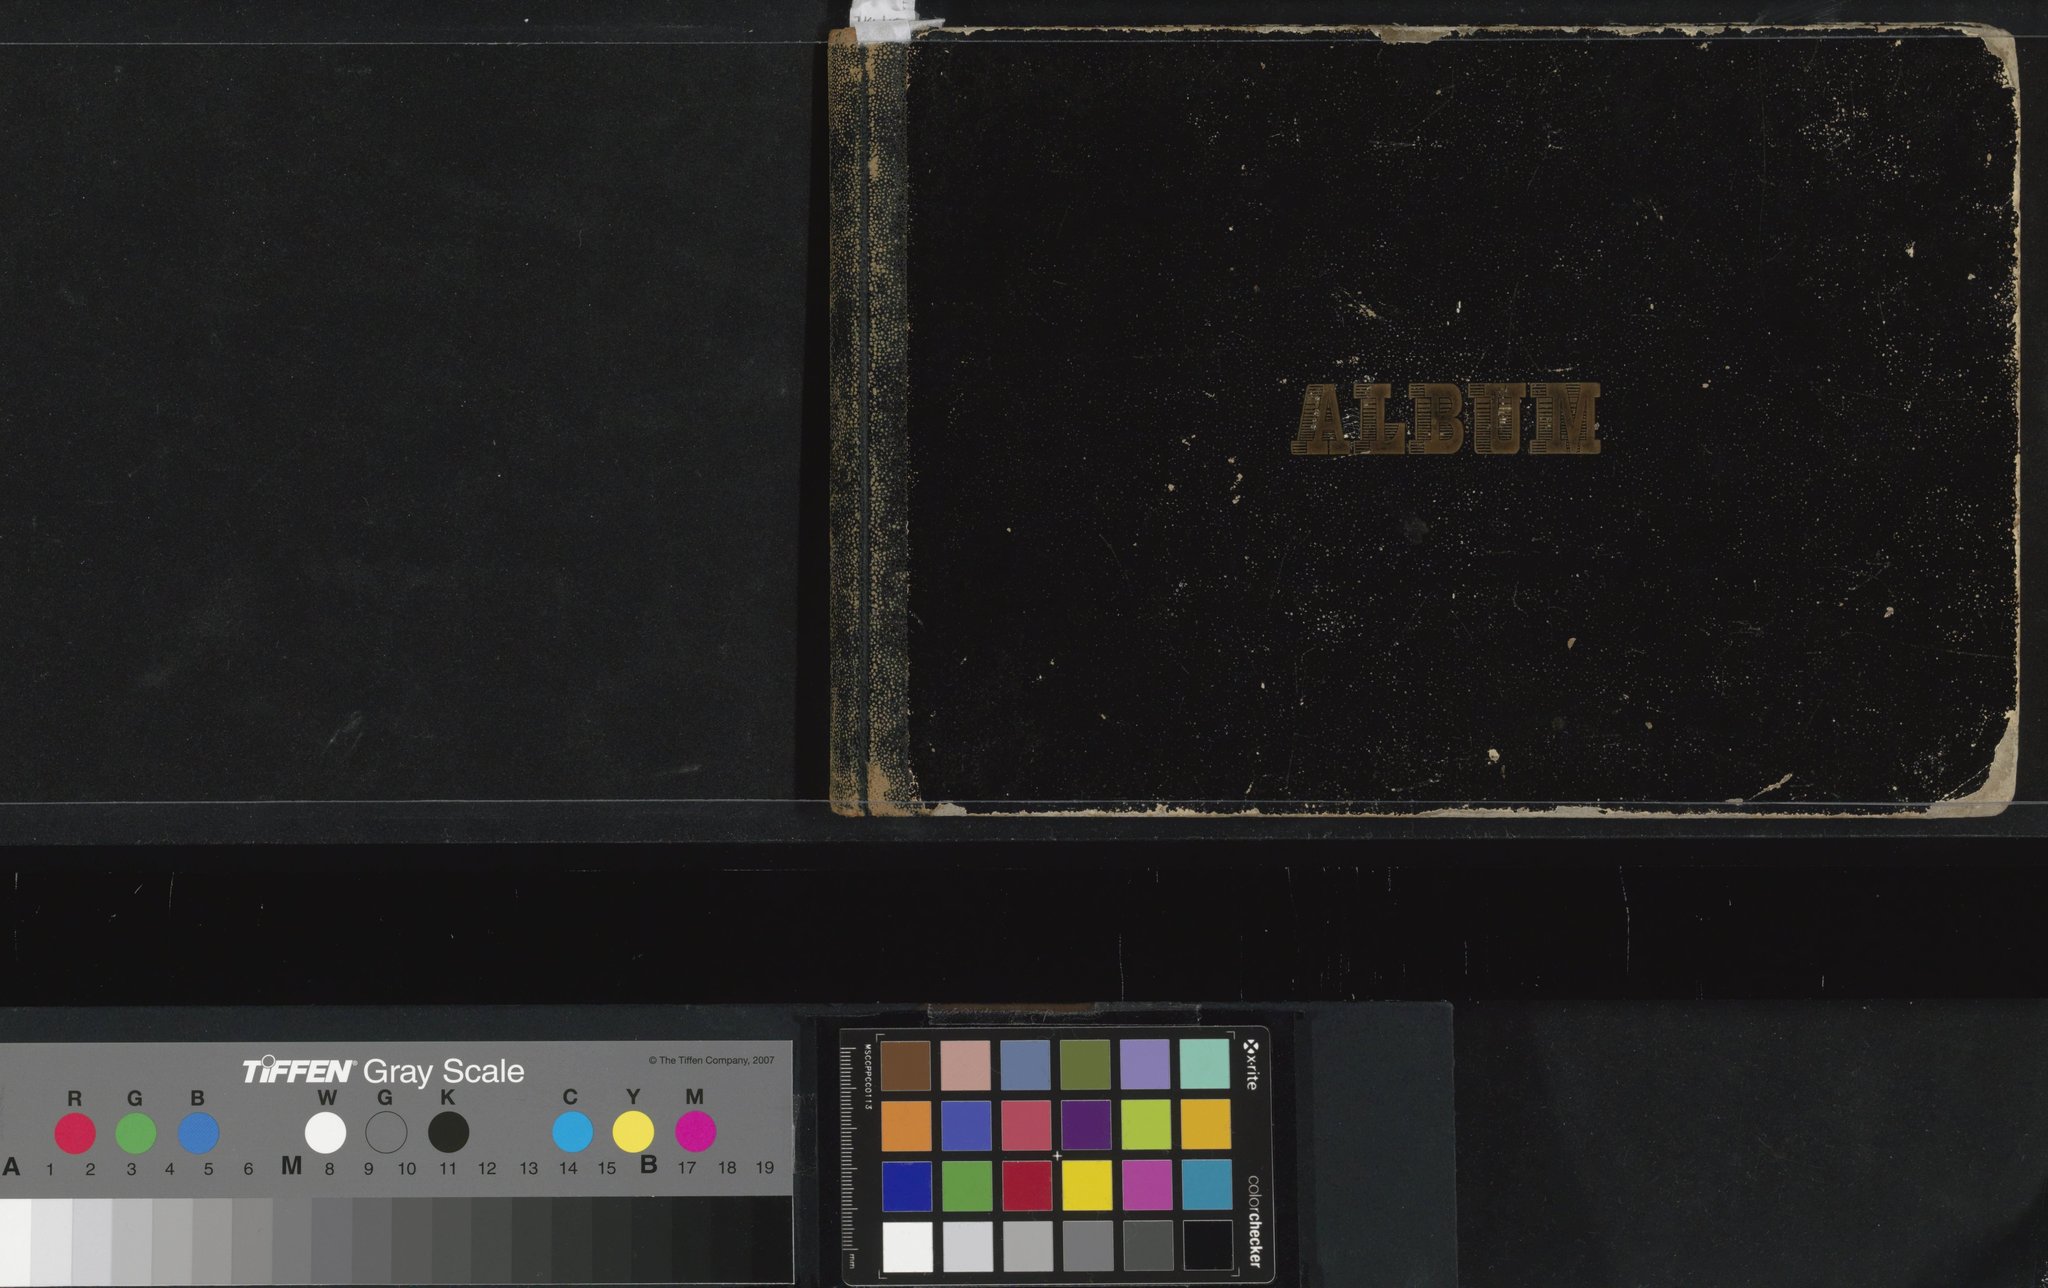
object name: sketchbook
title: Schetsboek met 58 bladen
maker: isaac gosschalk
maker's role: draughtsman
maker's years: 1838-1907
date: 1862-1867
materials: ink, leather, paper, pencil, watercolor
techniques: brush, pen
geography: arnay-le-duc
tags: architectural detail, representation of real building (either existing or having existed), rotterdam, utrecht, amsterdam, gouda, hoorn (north holland)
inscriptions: date and inscription: ‘Schetsboek van den architect / I. Gosschalk – Amsterdam 1862-67 Jos H.G./ architectuur en ornamenten, meest naar de natuur/ stadsgezichten of gebouwen uit:/ Amsterdam (Vijgendam enz.)/ Naarden/ Utrecht/ Rotterdam/ Gouda/ Zwolle/ Alkmaar/ Bergen/ Hoorn/ Amsterdam/ Utrecht/ Bommel’, collector's mark: Lugt 2228a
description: Schetsboek bestaande uit 58 bladen met architectuurstudies in onder andere Amsterdam, Uelzen, Naarden, Baarn, Amersfoort, Utrecht, Rotterdam, Gouda, Zwolle, Alkmaar, Bergen, Hoorn, Arnay-le-Duc, Berlijn en Bommel. Bij het schetsboek zijn tevens twee documenten gevoegd: een uittreksel uit het geboorteregister van Amsterdam met de aangifte van de geboorte van de kunstenaar en een brief van Prins Hendrik der Nederlanden met de benoeming van Isaac Gosschalk tot lid van de jury van de Internationale Tuinbouwtentoonstelling in 1877. Tevens een lijst met notities van J.H. Gosschalk te Den Haag met geselecteerde werken voor een tentoonstelling over baksteenbouw in de negentiende eeuw.